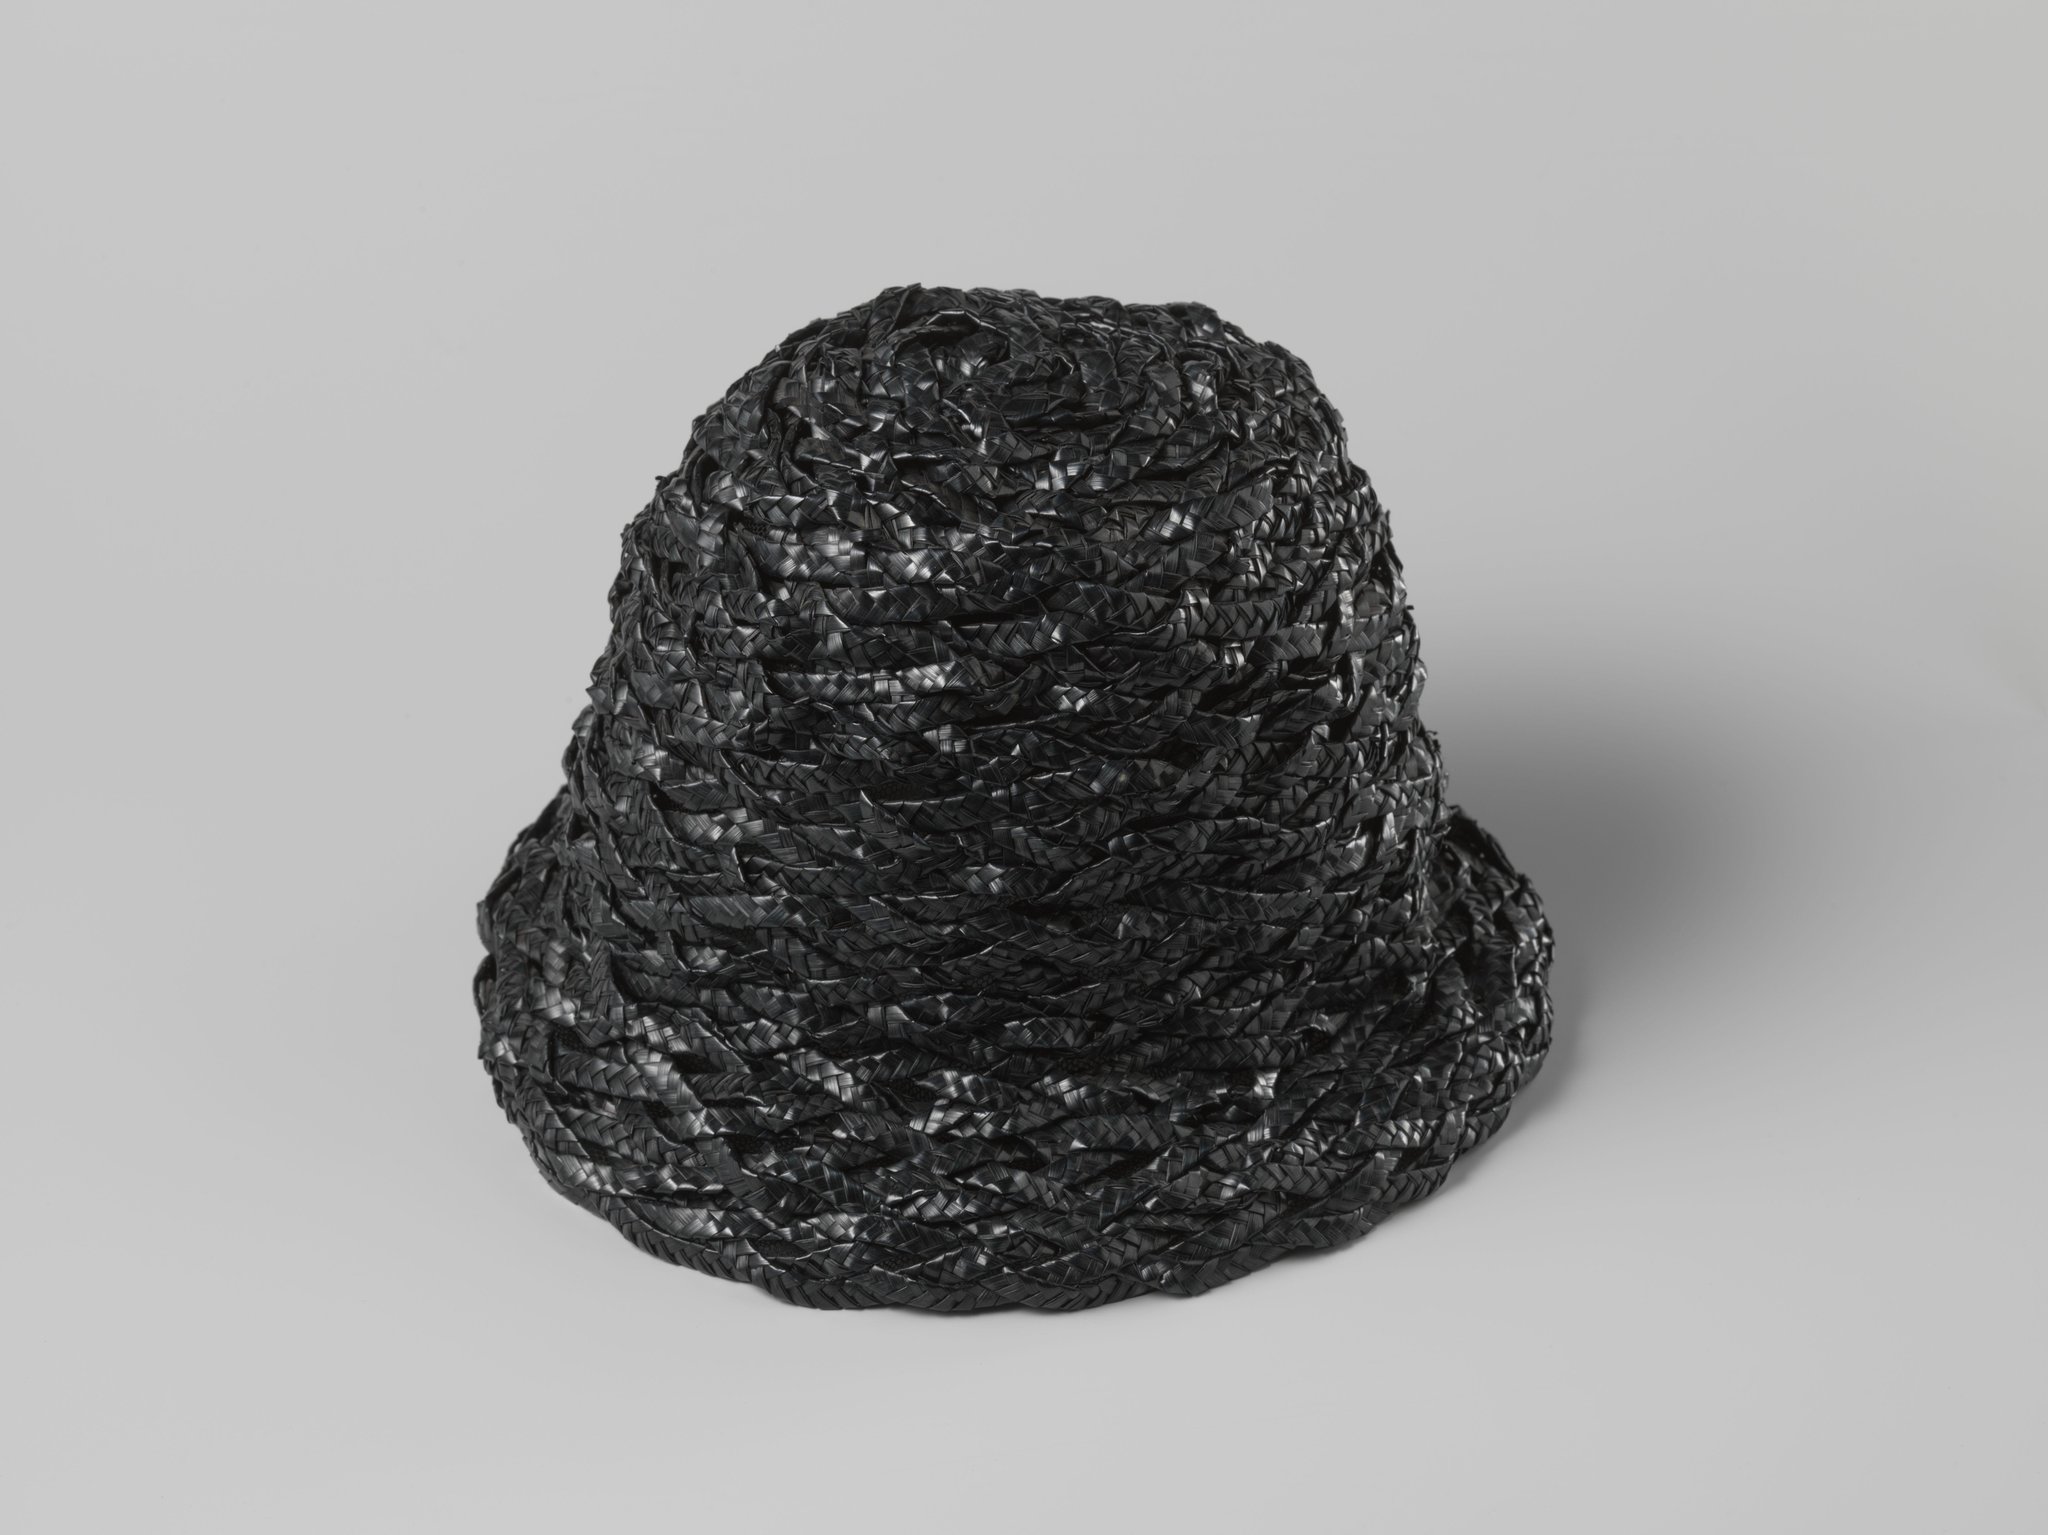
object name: hat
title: Hoed van gevlochten, zwart raffia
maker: paulette modes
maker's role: hoedenmaakster, modiste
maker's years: 1900-1984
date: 1955-1960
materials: raffia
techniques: braiding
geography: paris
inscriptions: label: ‘PAULETTE’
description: Hoed van gevlochten, zwart raffia.De hoed heeft een hoge bol en een neerhangende rand. De hoed is gevoerd met zwarte tule.